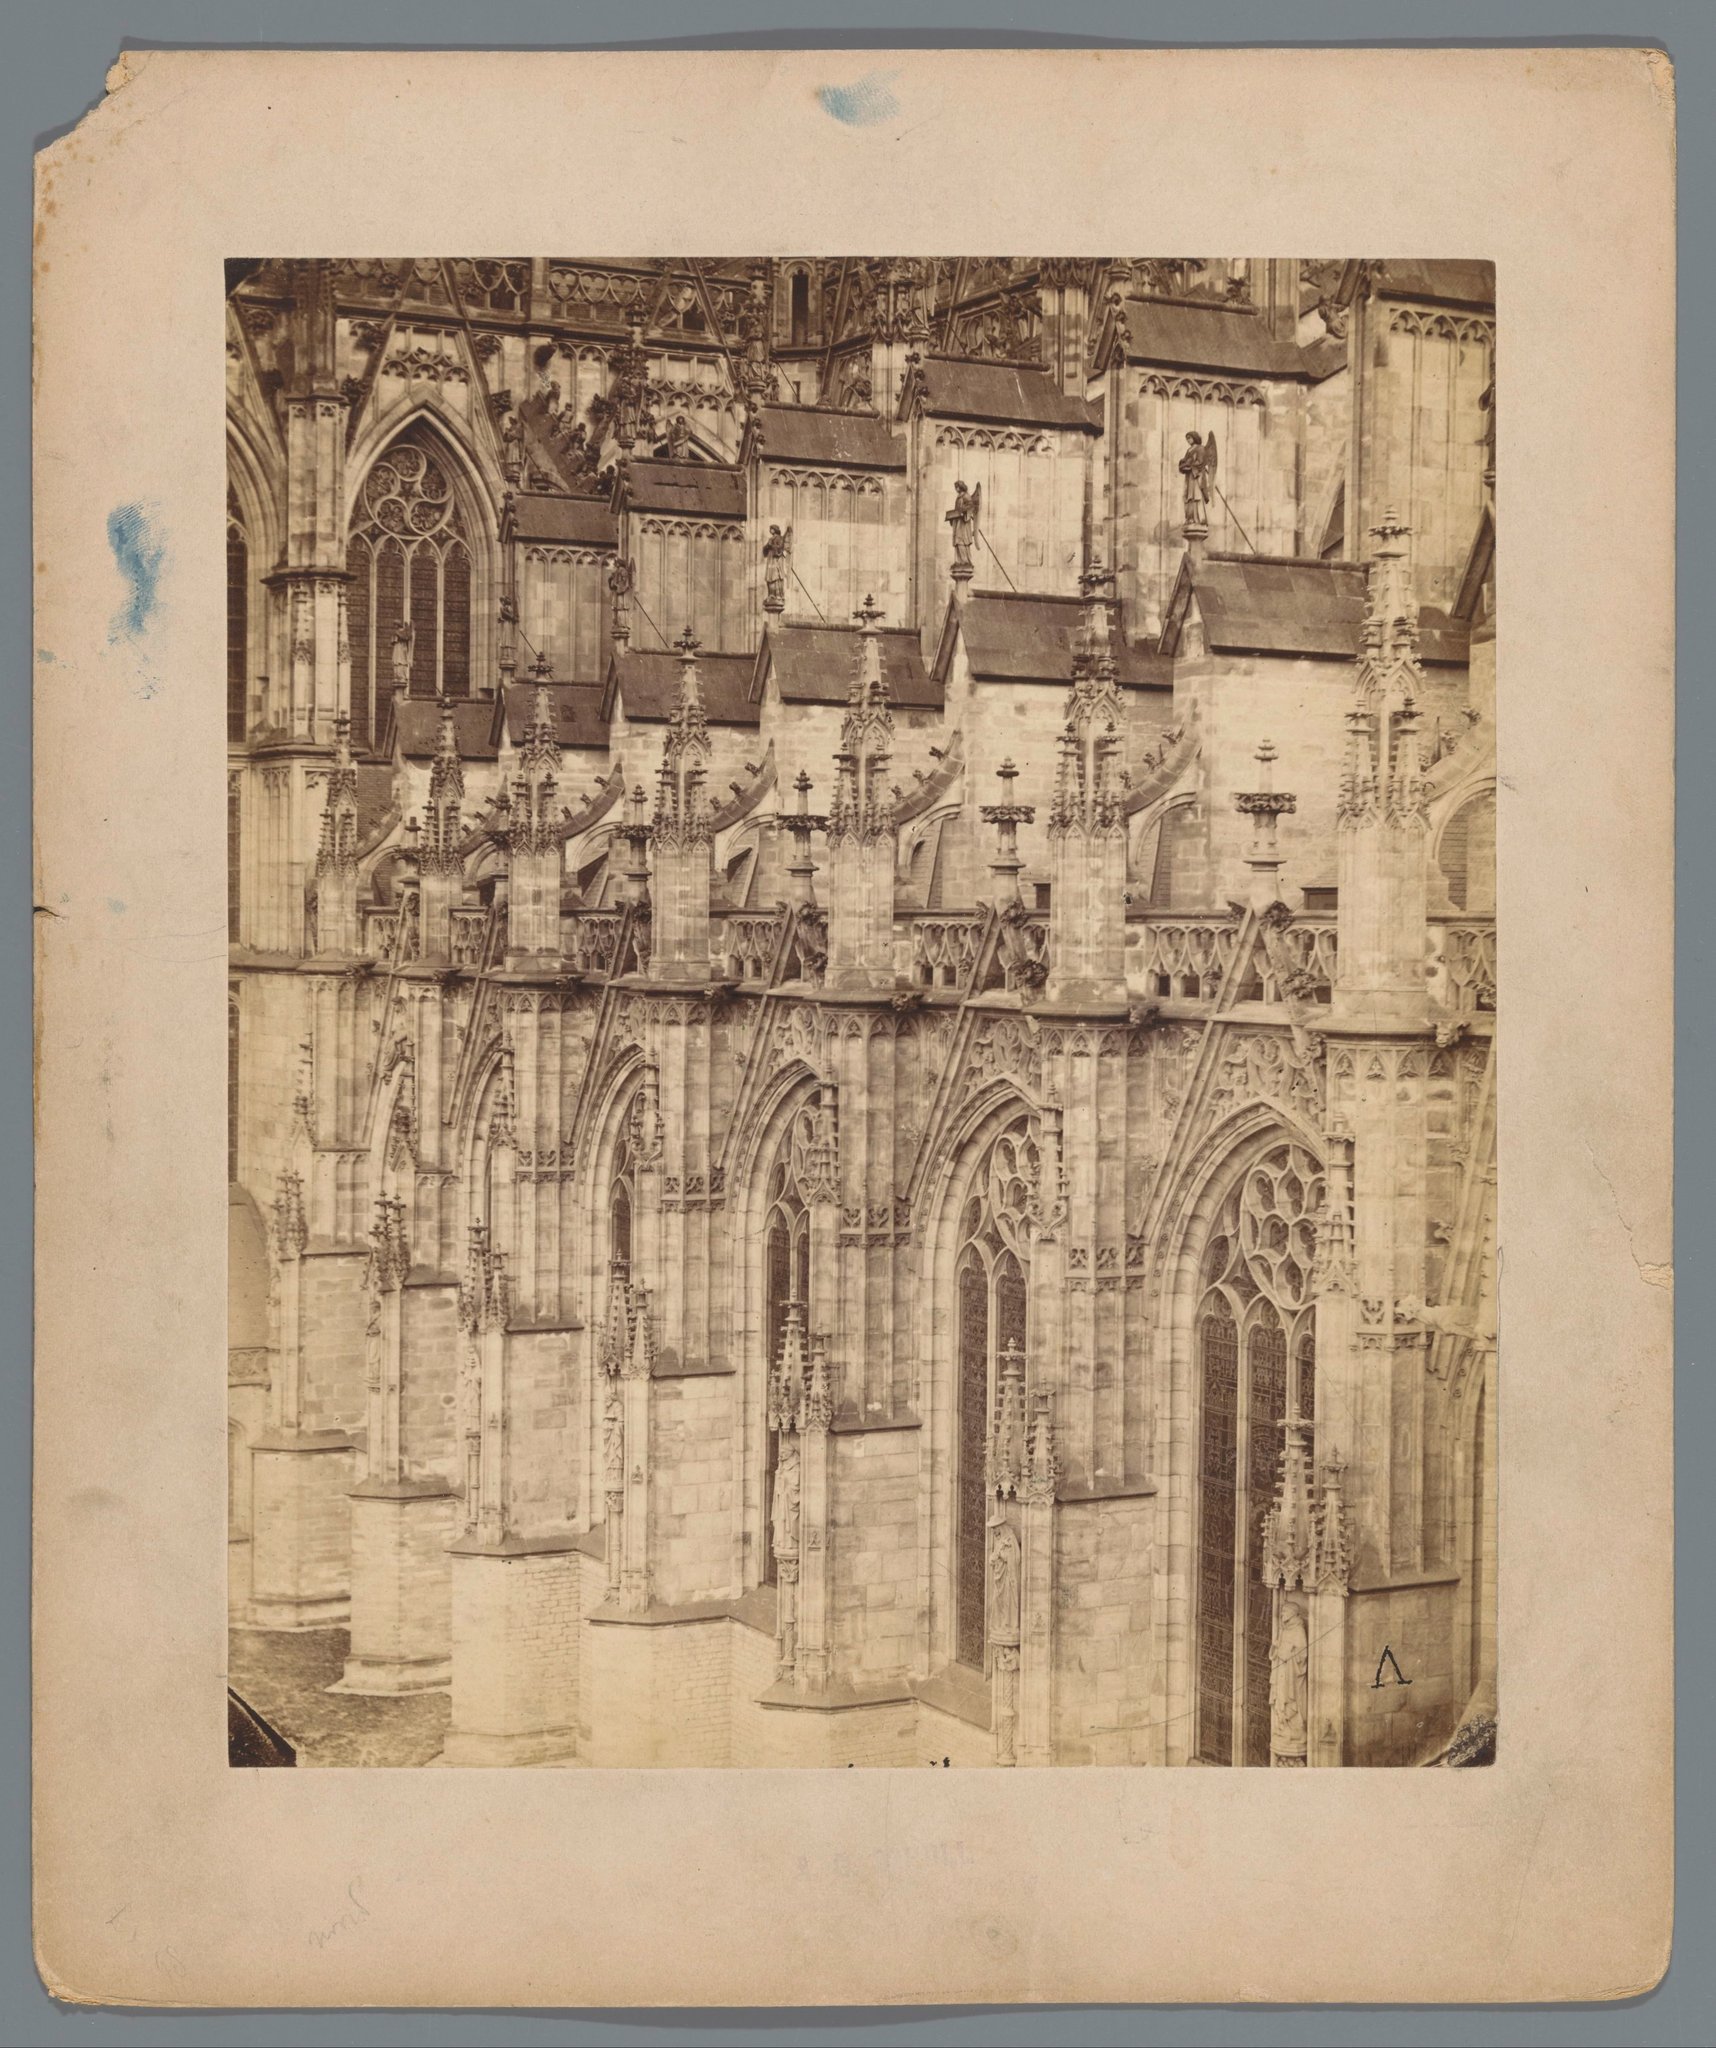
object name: photograph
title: Deel van de gevel van de Sint-Janskathedraal te 's-Hertogenbosch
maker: antonius godefridus schull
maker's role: fotograaf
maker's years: 1819-1896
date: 1875-1900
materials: cardboard, photographic support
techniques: albumen print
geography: den bosch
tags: church (exterior), façade (of house or building)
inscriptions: collector's mark: Lugt 3937, name: ‘A. G. SCHULL’